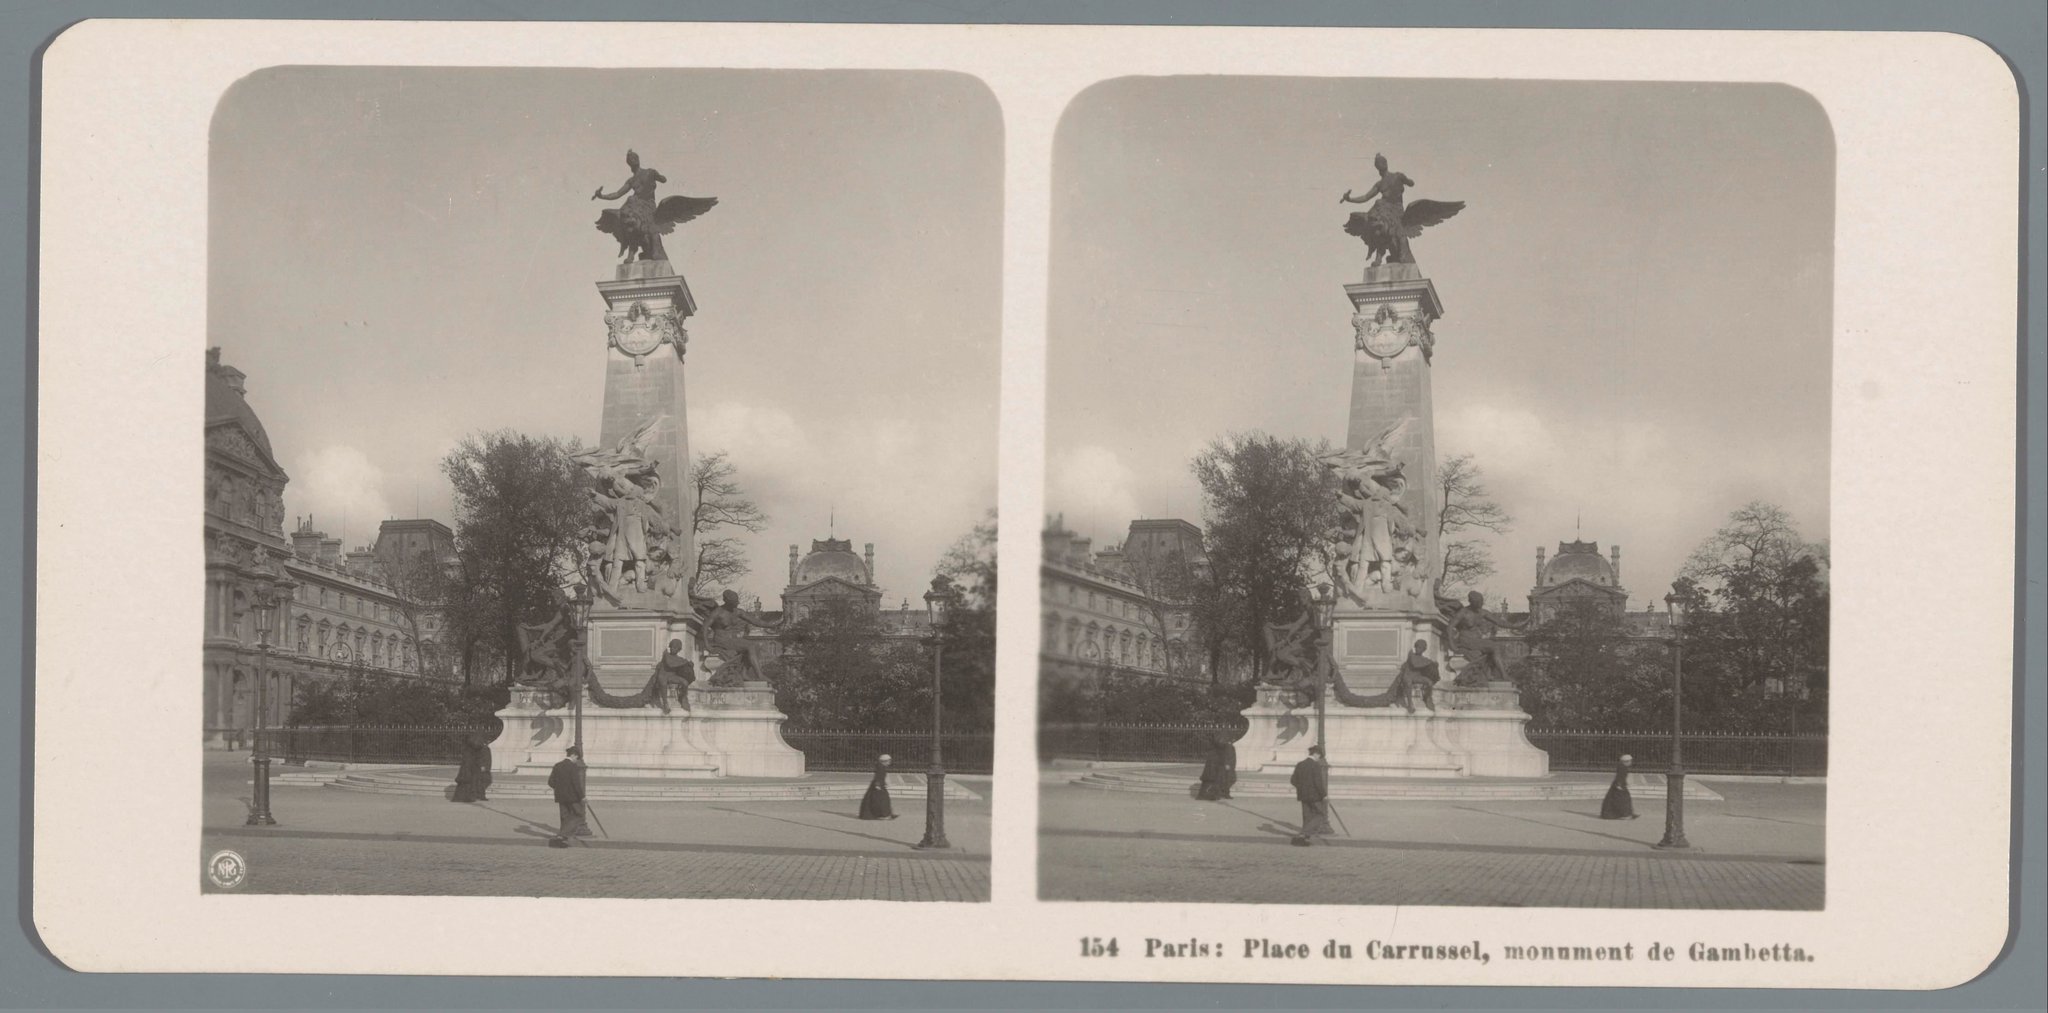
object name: stereograph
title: Gezicht op het monument voor Léon Gambetta op de Place du Carrousel te Parijs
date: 1895-1905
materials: cardboard, photographic support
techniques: gelatin silver print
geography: paris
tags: monument, statue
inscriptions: number: ‘154’, inscription: ‘NPG’